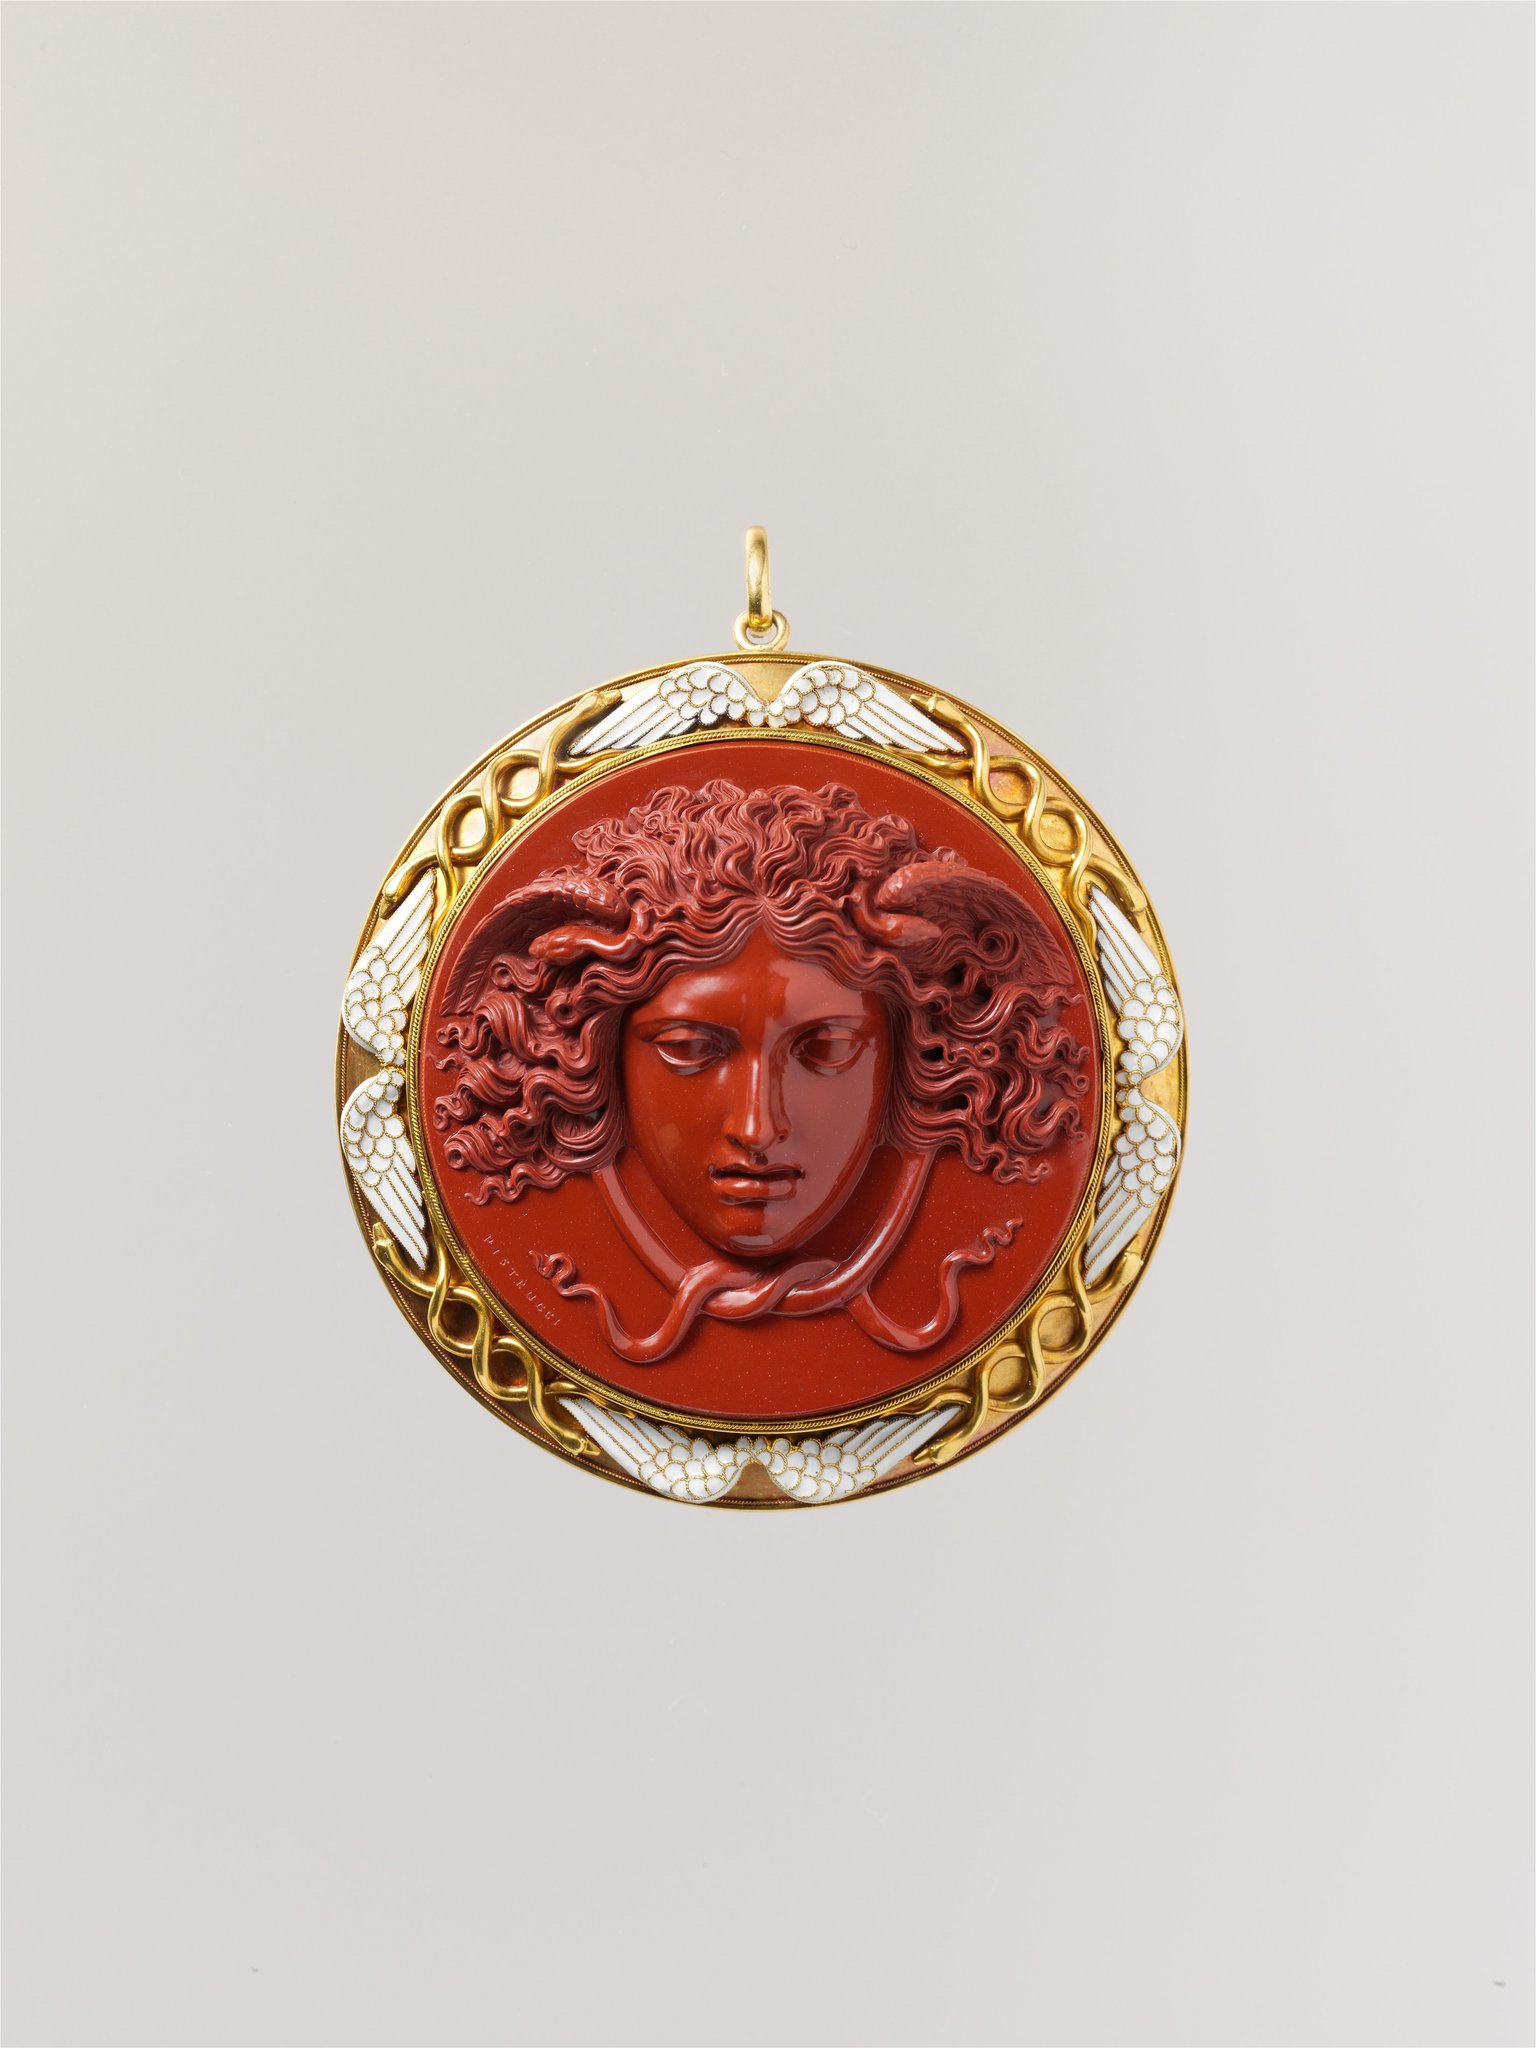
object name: cameo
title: Head of Medusa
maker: benedetto pistrucci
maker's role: artist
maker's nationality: italian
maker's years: 1783-1855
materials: enamel, gold, jasper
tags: heads,medusa